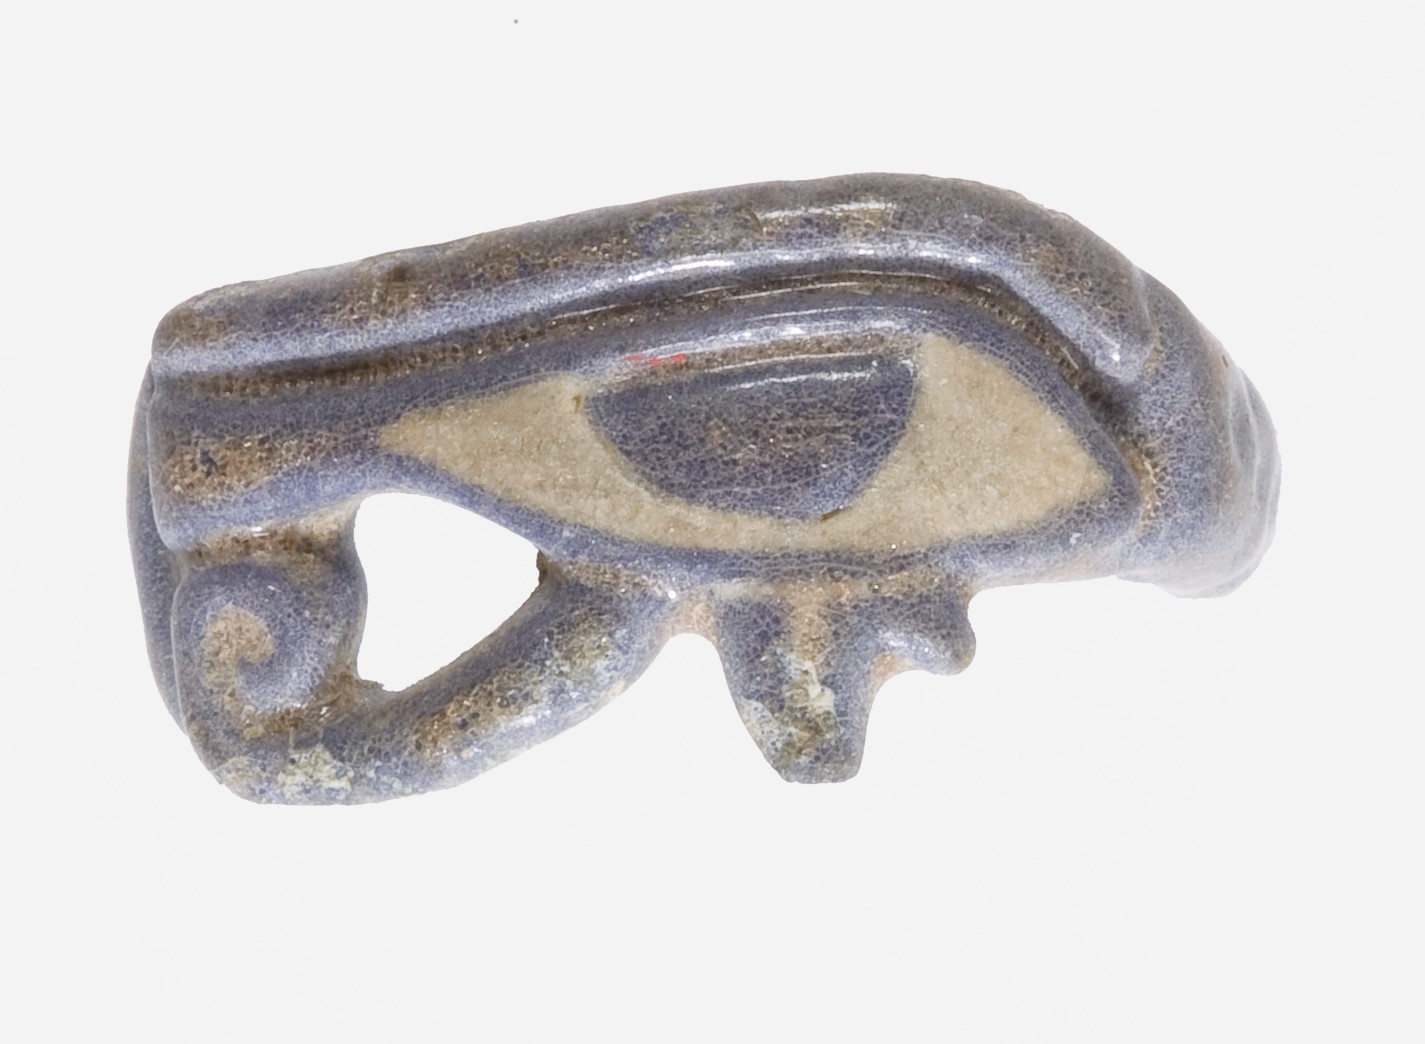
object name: ring, wedjat eye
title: Fragmentary Ring Decorated with a Wedjat Eye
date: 1390-1352 BCE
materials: faience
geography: egypt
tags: eyes